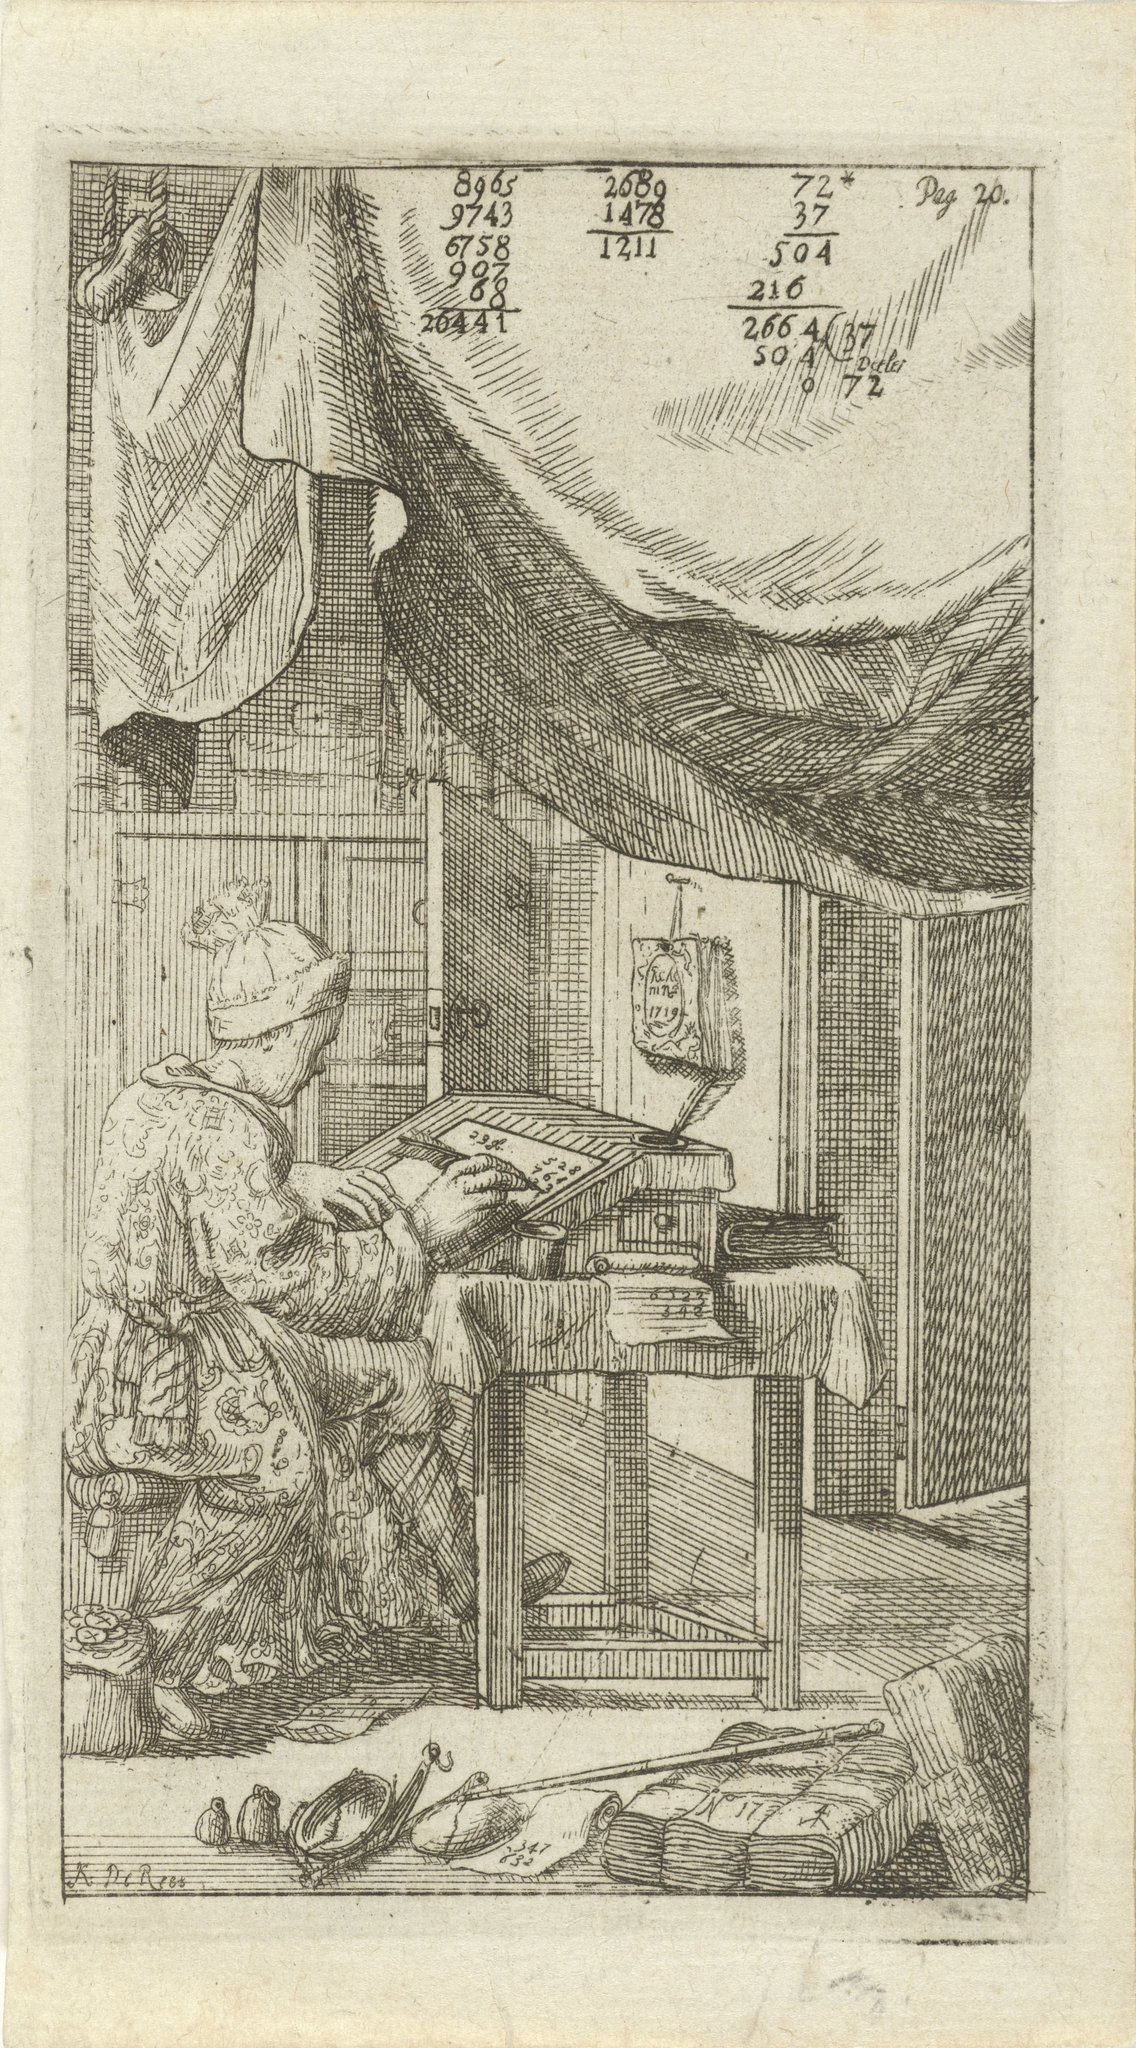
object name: print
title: Rekenaar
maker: kaspar frans de rees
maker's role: print maker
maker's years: 1690-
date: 1719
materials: paper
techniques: etching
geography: netherlands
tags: counting, calculating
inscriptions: date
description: In een vertrek zit een jongen aan een bureau te rekenen. Op de draperie boven het bureau staat een aantal sommen.